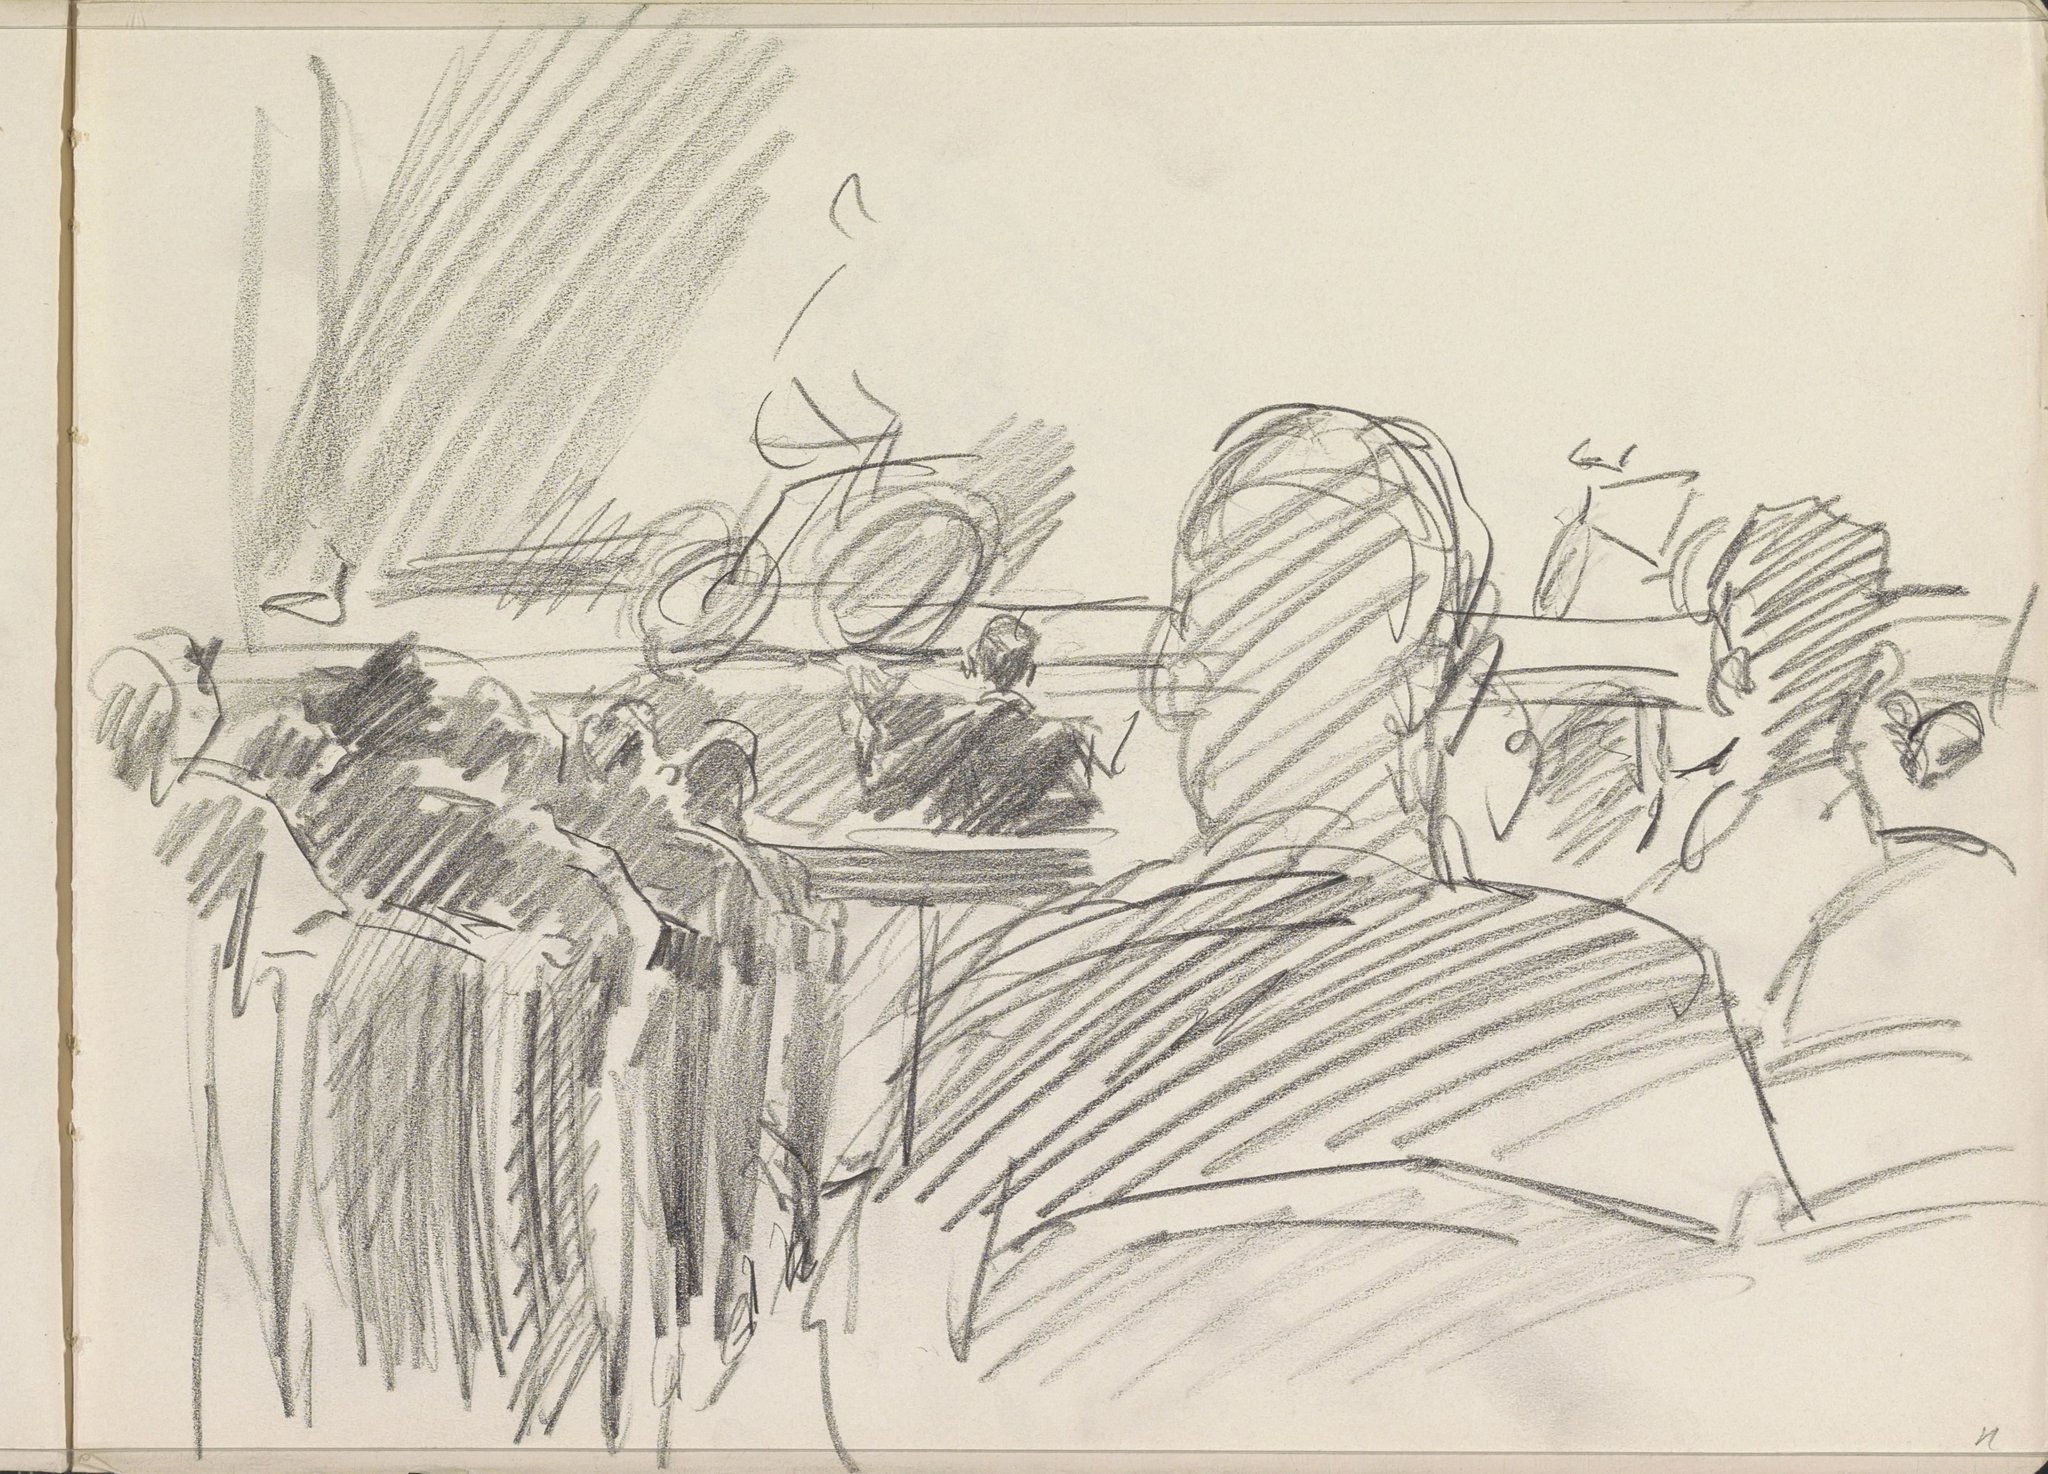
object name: sketchbook leaf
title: Fietsende acrobaat op het toneel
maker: isaac israels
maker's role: draughtsman, painter, print maker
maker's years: 1865-1934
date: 1875-1934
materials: paper, pencil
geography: the hague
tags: theatre, theatrical performance, acrobat ~ circus, bicycle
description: Vooraan toeschouwers en de dirigent in de orkestbak. Blad 11 recto uit schetsboek V met 33 bladen.